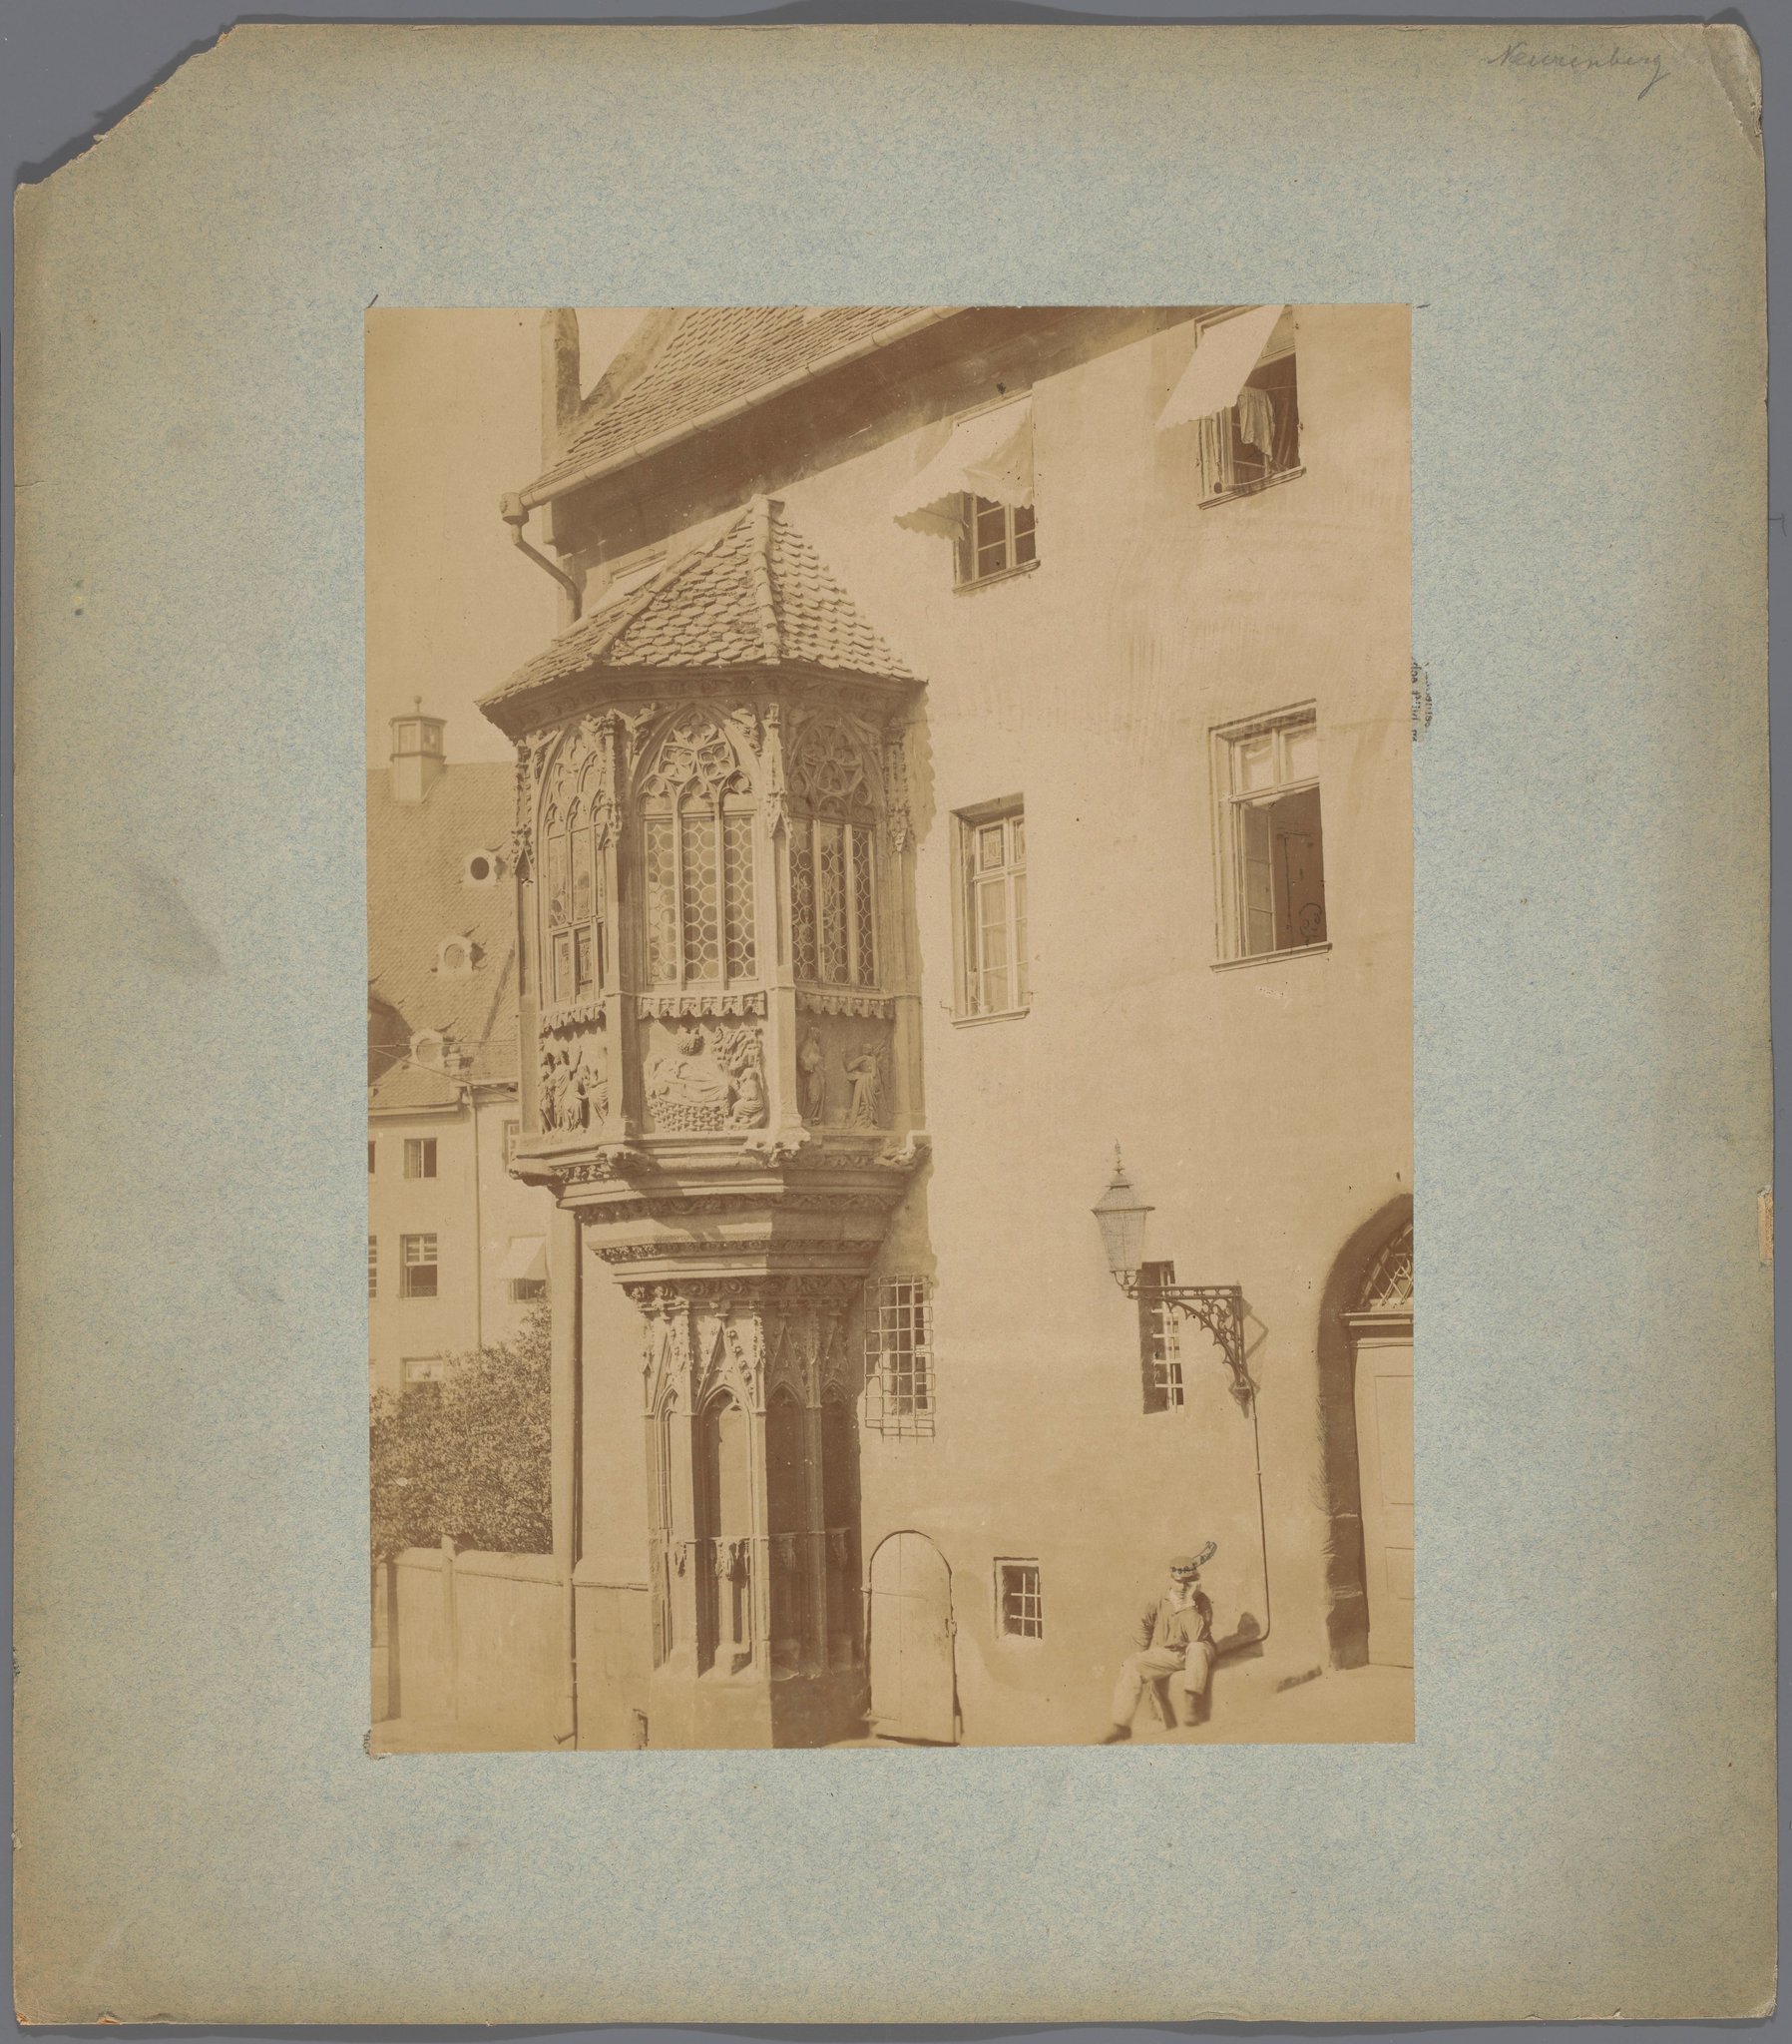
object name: photograph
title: Gedecoreerde erker in Neurenberg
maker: Anonymous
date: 1850-1900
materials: cardboard, photographic support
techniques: albumen print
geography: nuremberg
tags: façade (of house or building)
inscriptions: annotation: ‘H’, annotation: ‘Neurenberg’, collector's mark: ‘Rijks-normaalschool voor teekenonderwijzers Amsterdam’ Lugt 3937, annotation: ‘Neurenberg’